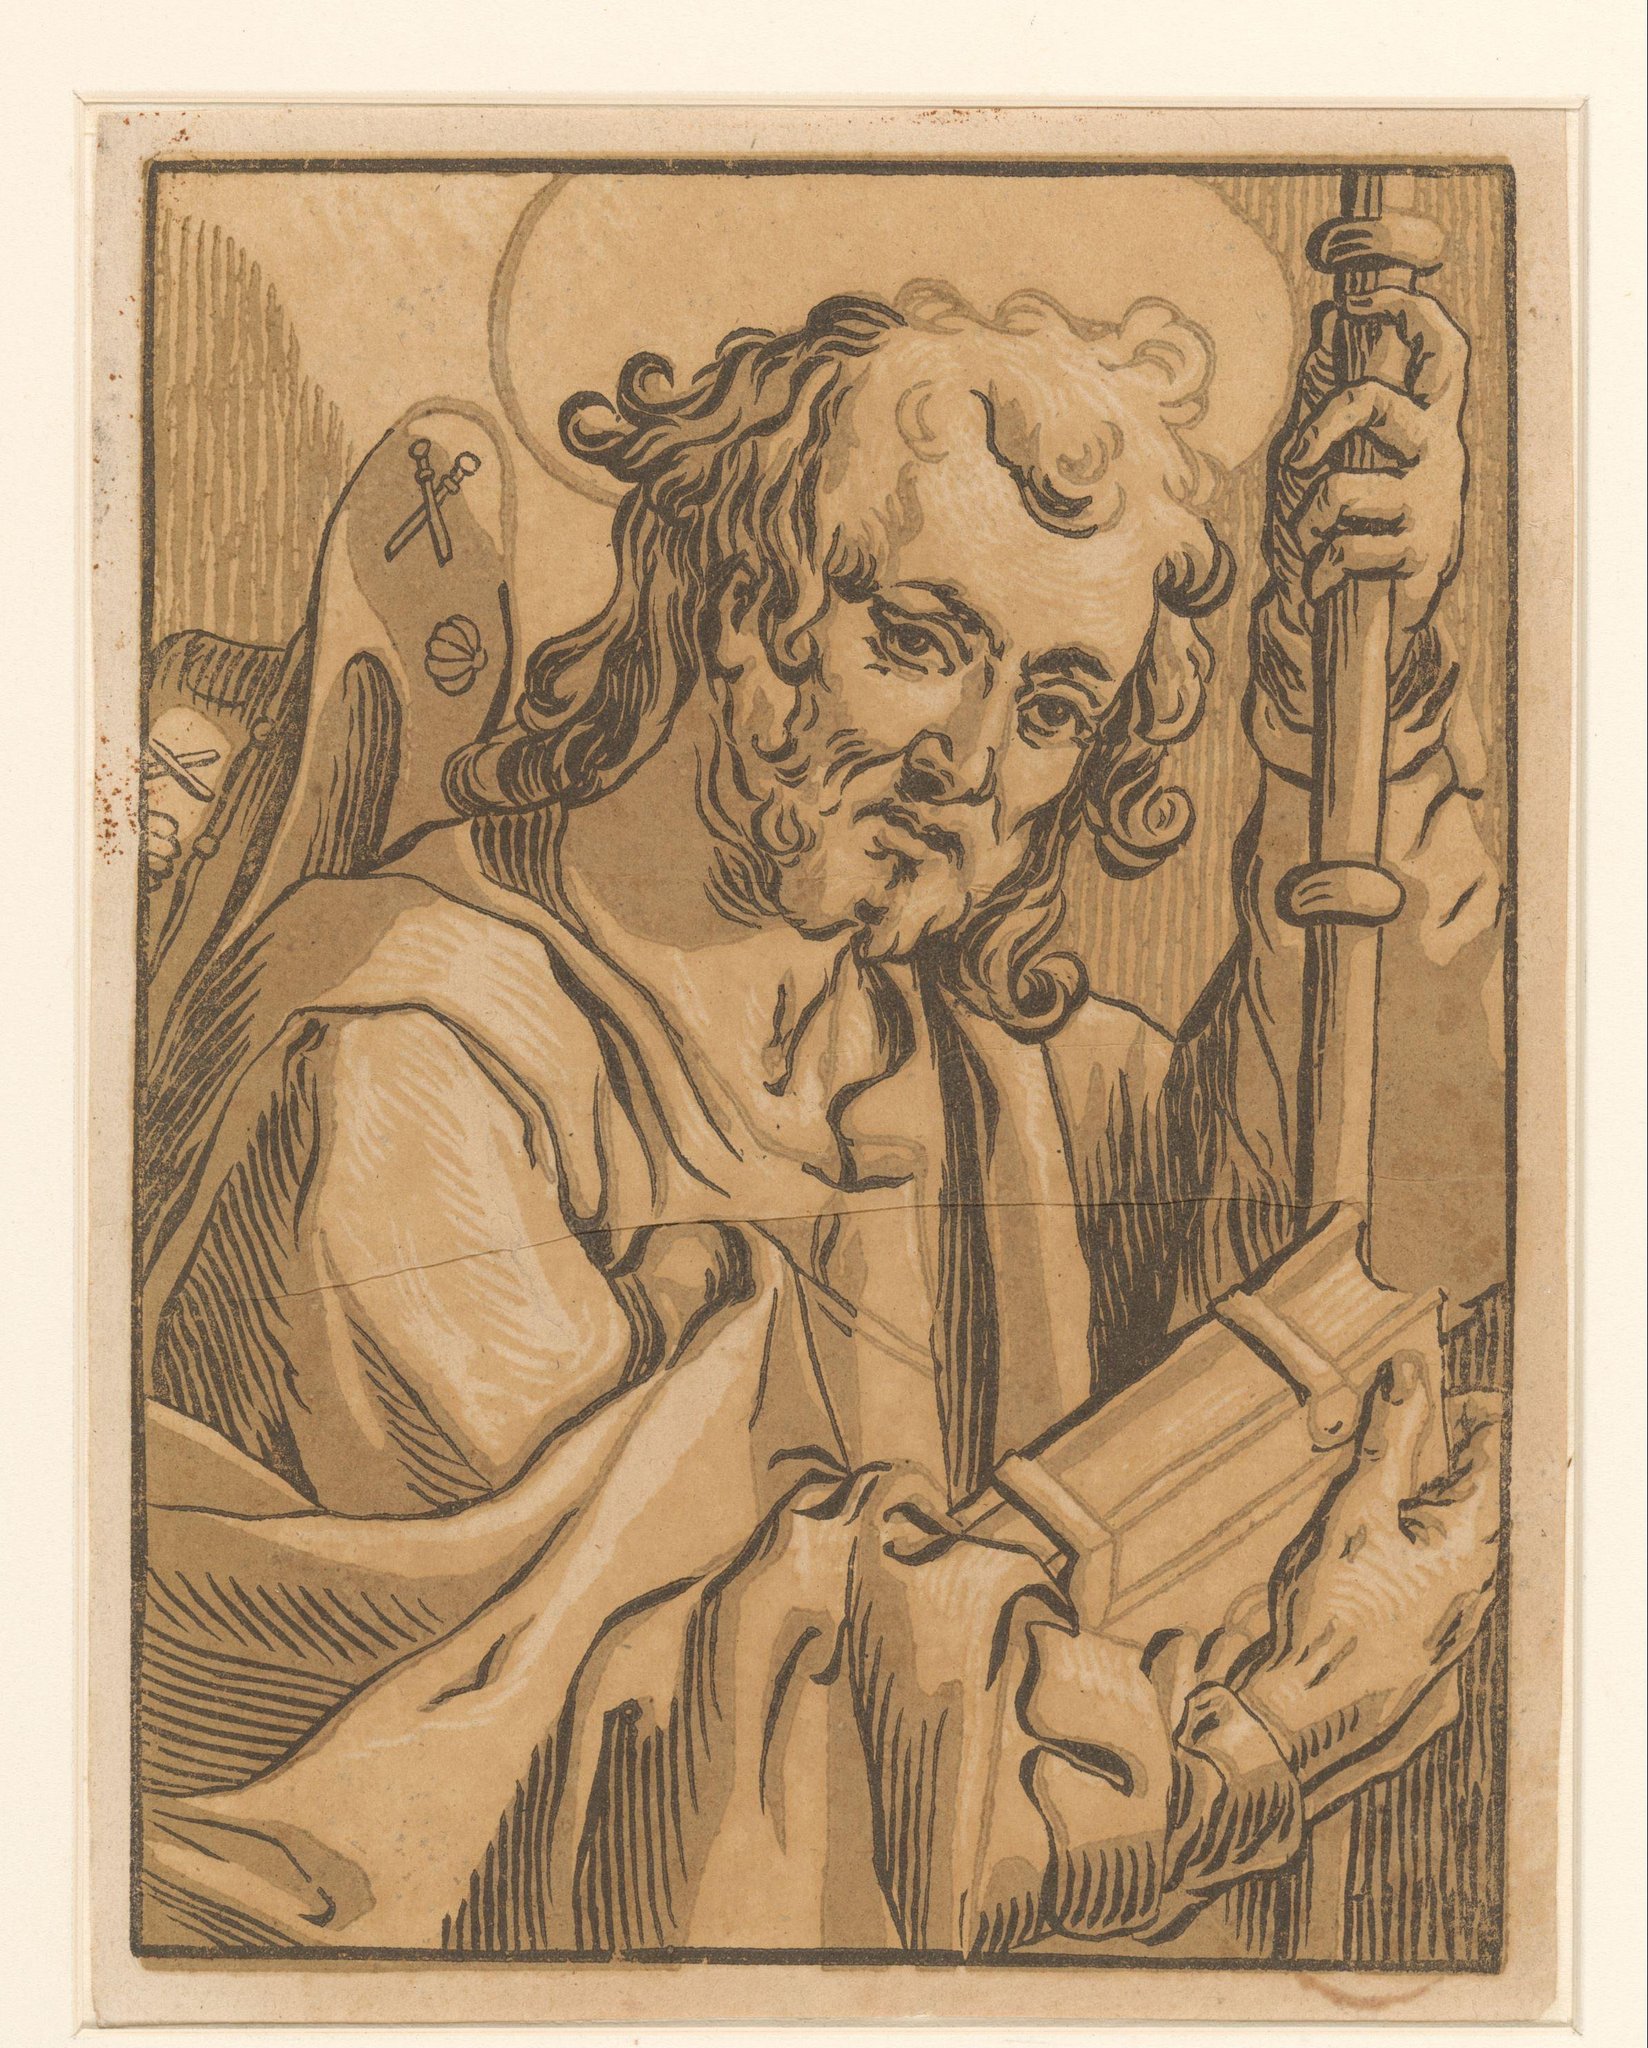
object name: print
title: Christus en de twaalf apostelen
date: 1600-1669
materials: paper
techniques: woodcut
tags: the apostle james the great; possible attributes: book, pilgrim's cloak, hat, shell, staff, and wallet, scroll, sword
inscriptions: collector's mark: Lugt 240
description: Onderdeel van een serie van twaalf prenten met afzonderlijk Christus en de apostelen.